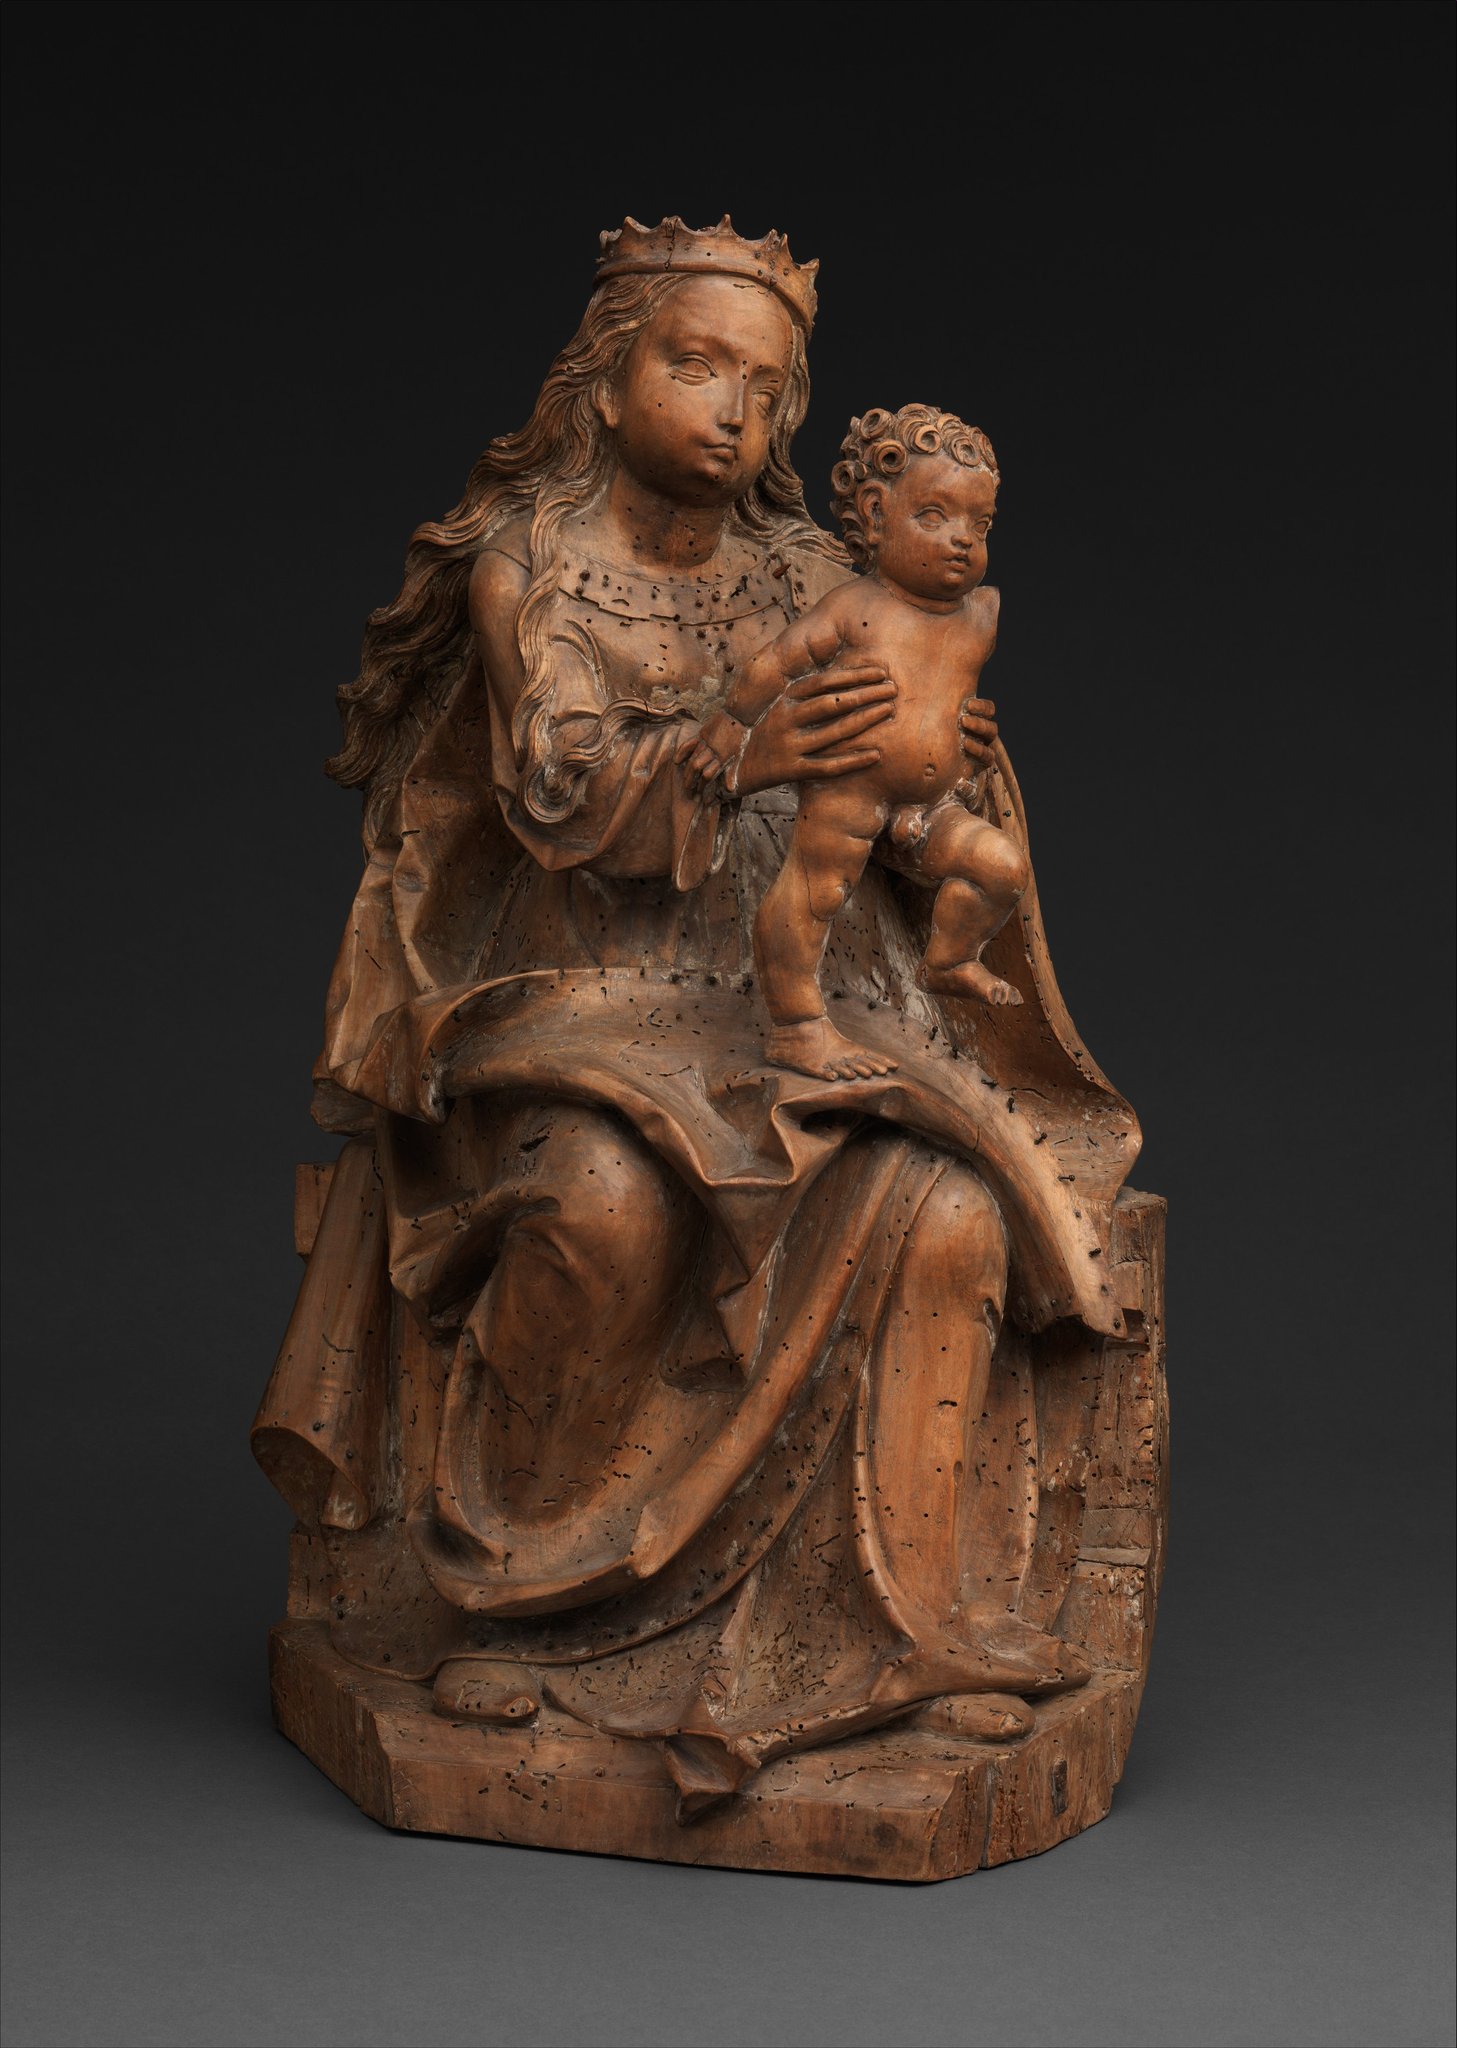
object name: statuette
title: Virgin and Child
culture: german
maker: master of rabenden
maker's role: artist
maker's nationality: german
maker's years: 1500-1530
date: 1510-1515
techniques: polychromy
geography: germany